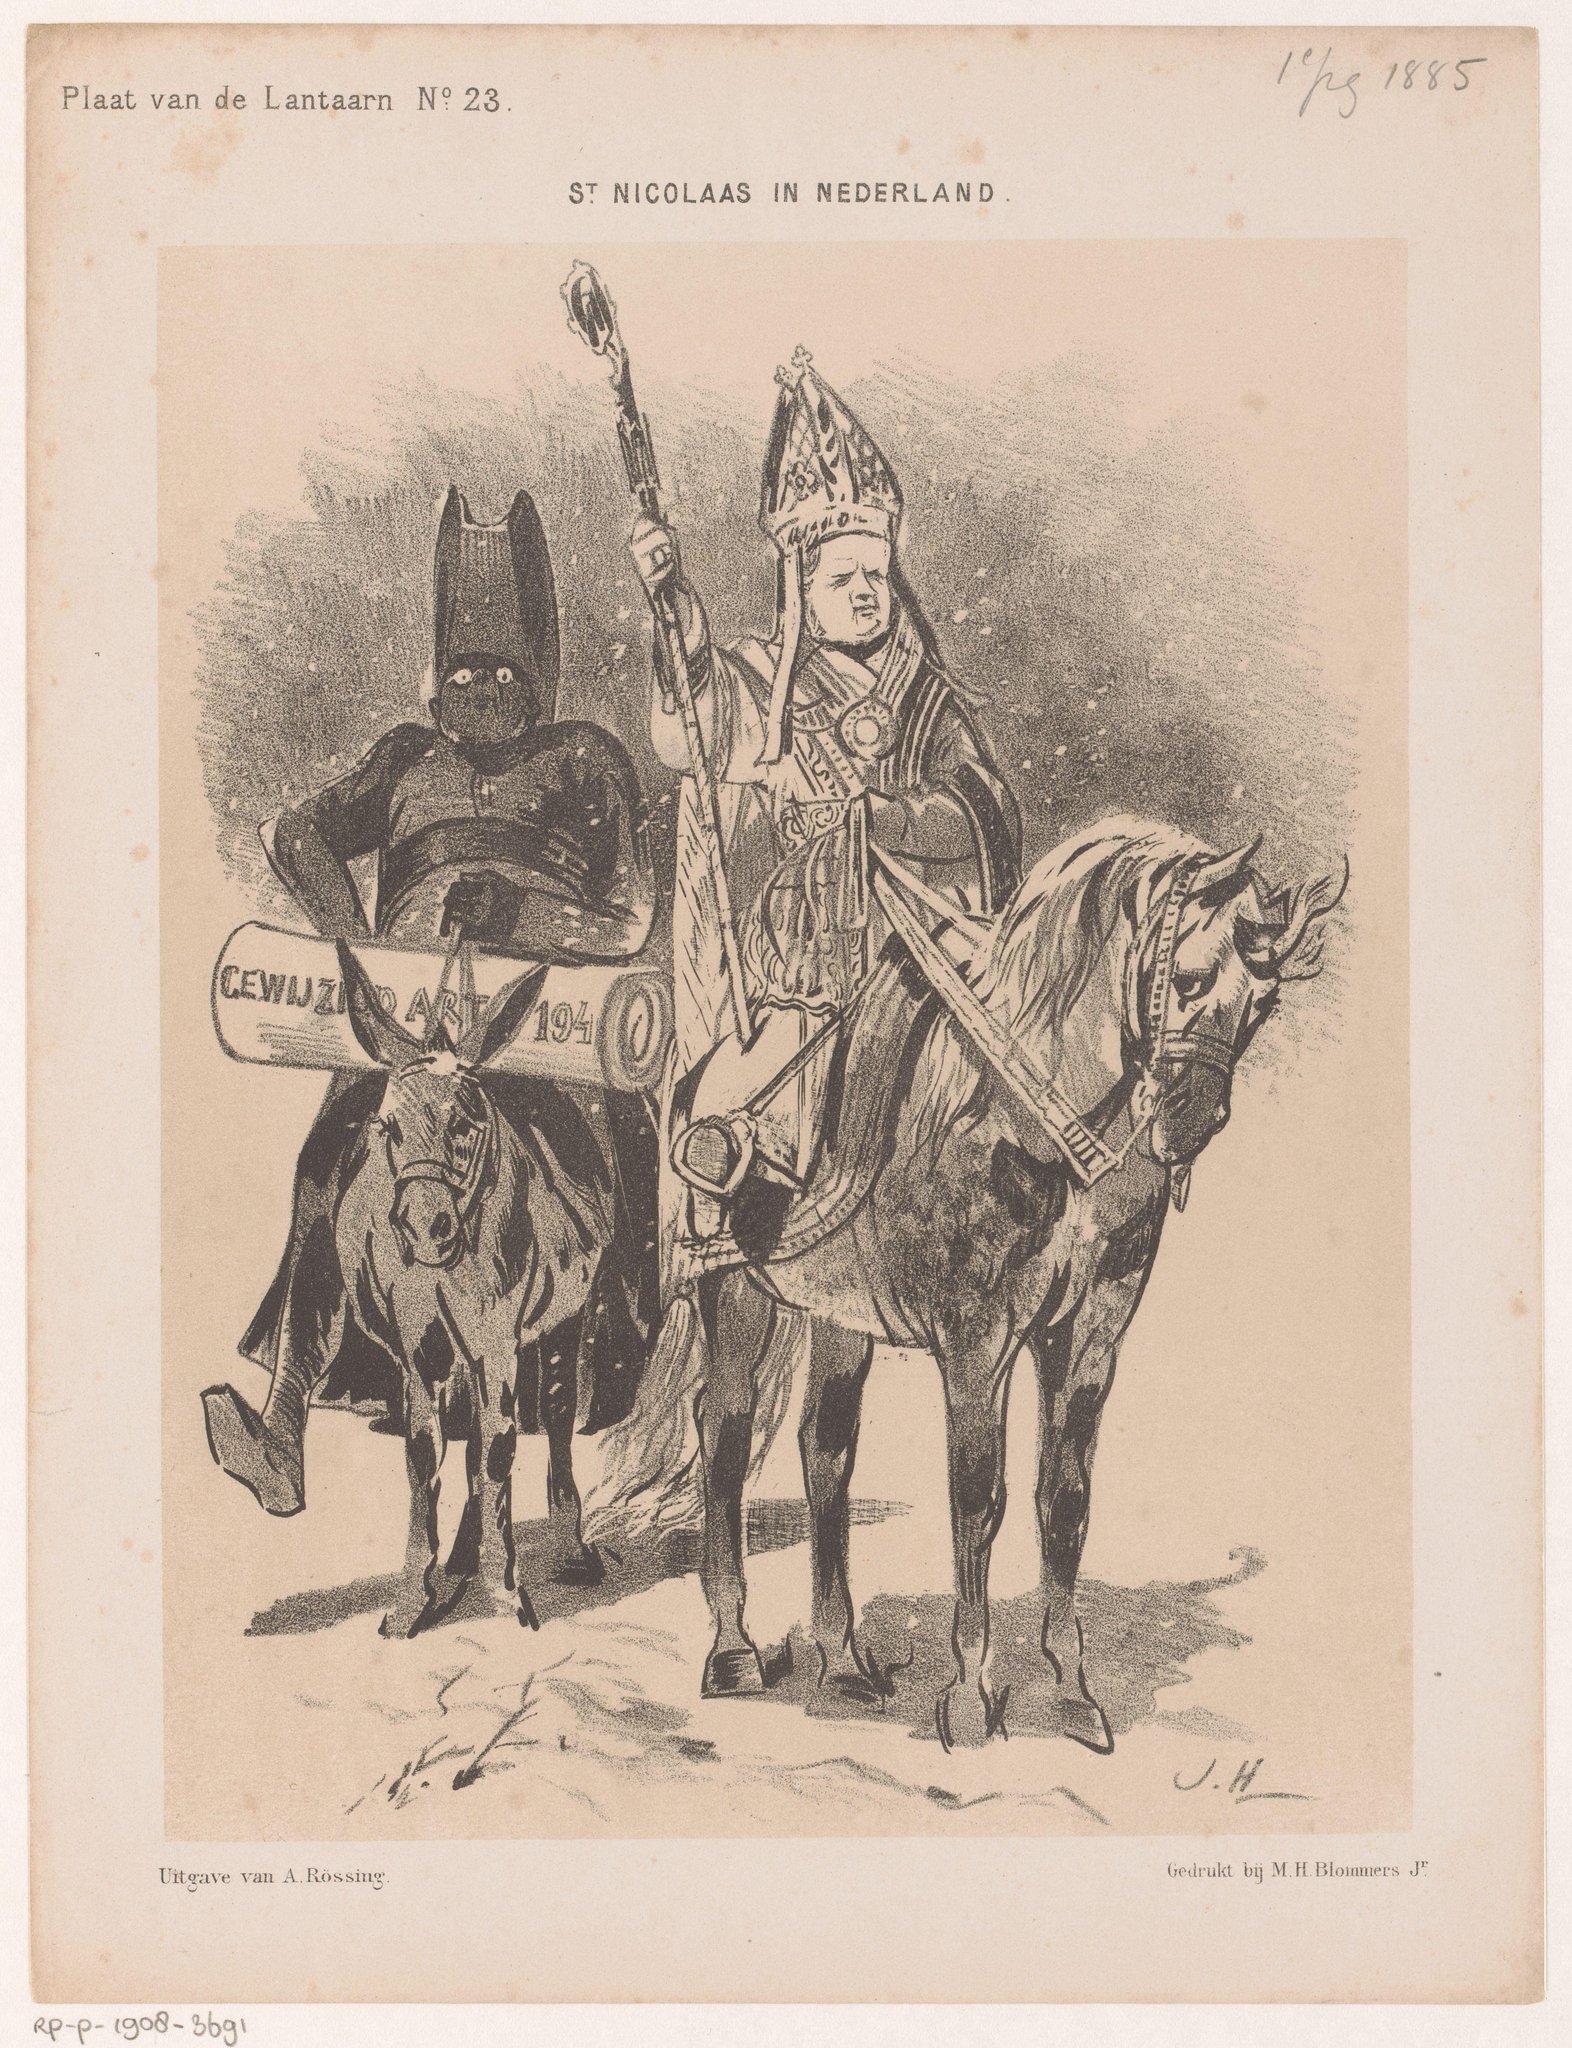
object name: print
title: Spotprent over wijziging binnen de grondwet in 1885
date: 1885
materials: paper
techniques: lithograph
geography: the hague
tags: rome, priest, herman johannes aloysius maria schaepman, amsterdam, the hague, politician, riding a horse, ass, or mule; rider, horseman, robber, festivities on st. nicholas (eve) (december 5), political caricatures and satires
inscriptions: collector's mark: Lugt 2228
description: Het kabinet van Jan Heemskerk Azn, hier afgebeeld als Sinterklaas, deed in 1885 een aantal voorstellen tot herziening van de grondwet maar liet het onderwijs ongemoeid. Voor de katholieken en anti-revolutionairen binnen de kamer was dat onaanvaardbaar en zij dreigden daarom tegen alle voorstellen te stemmen, tenzij er een voorstel kwam wat artikel 194 betrof. Dit werd 'politieke struikroverij' genoemd. Naast Van Heemskerk Azn. zit dan ook Herman Schaepman, gekleed als struikrover, op een ezel met het artikel 194 in zijn schoot. Deze prent werd uitgegeven bij De Lantaarn.